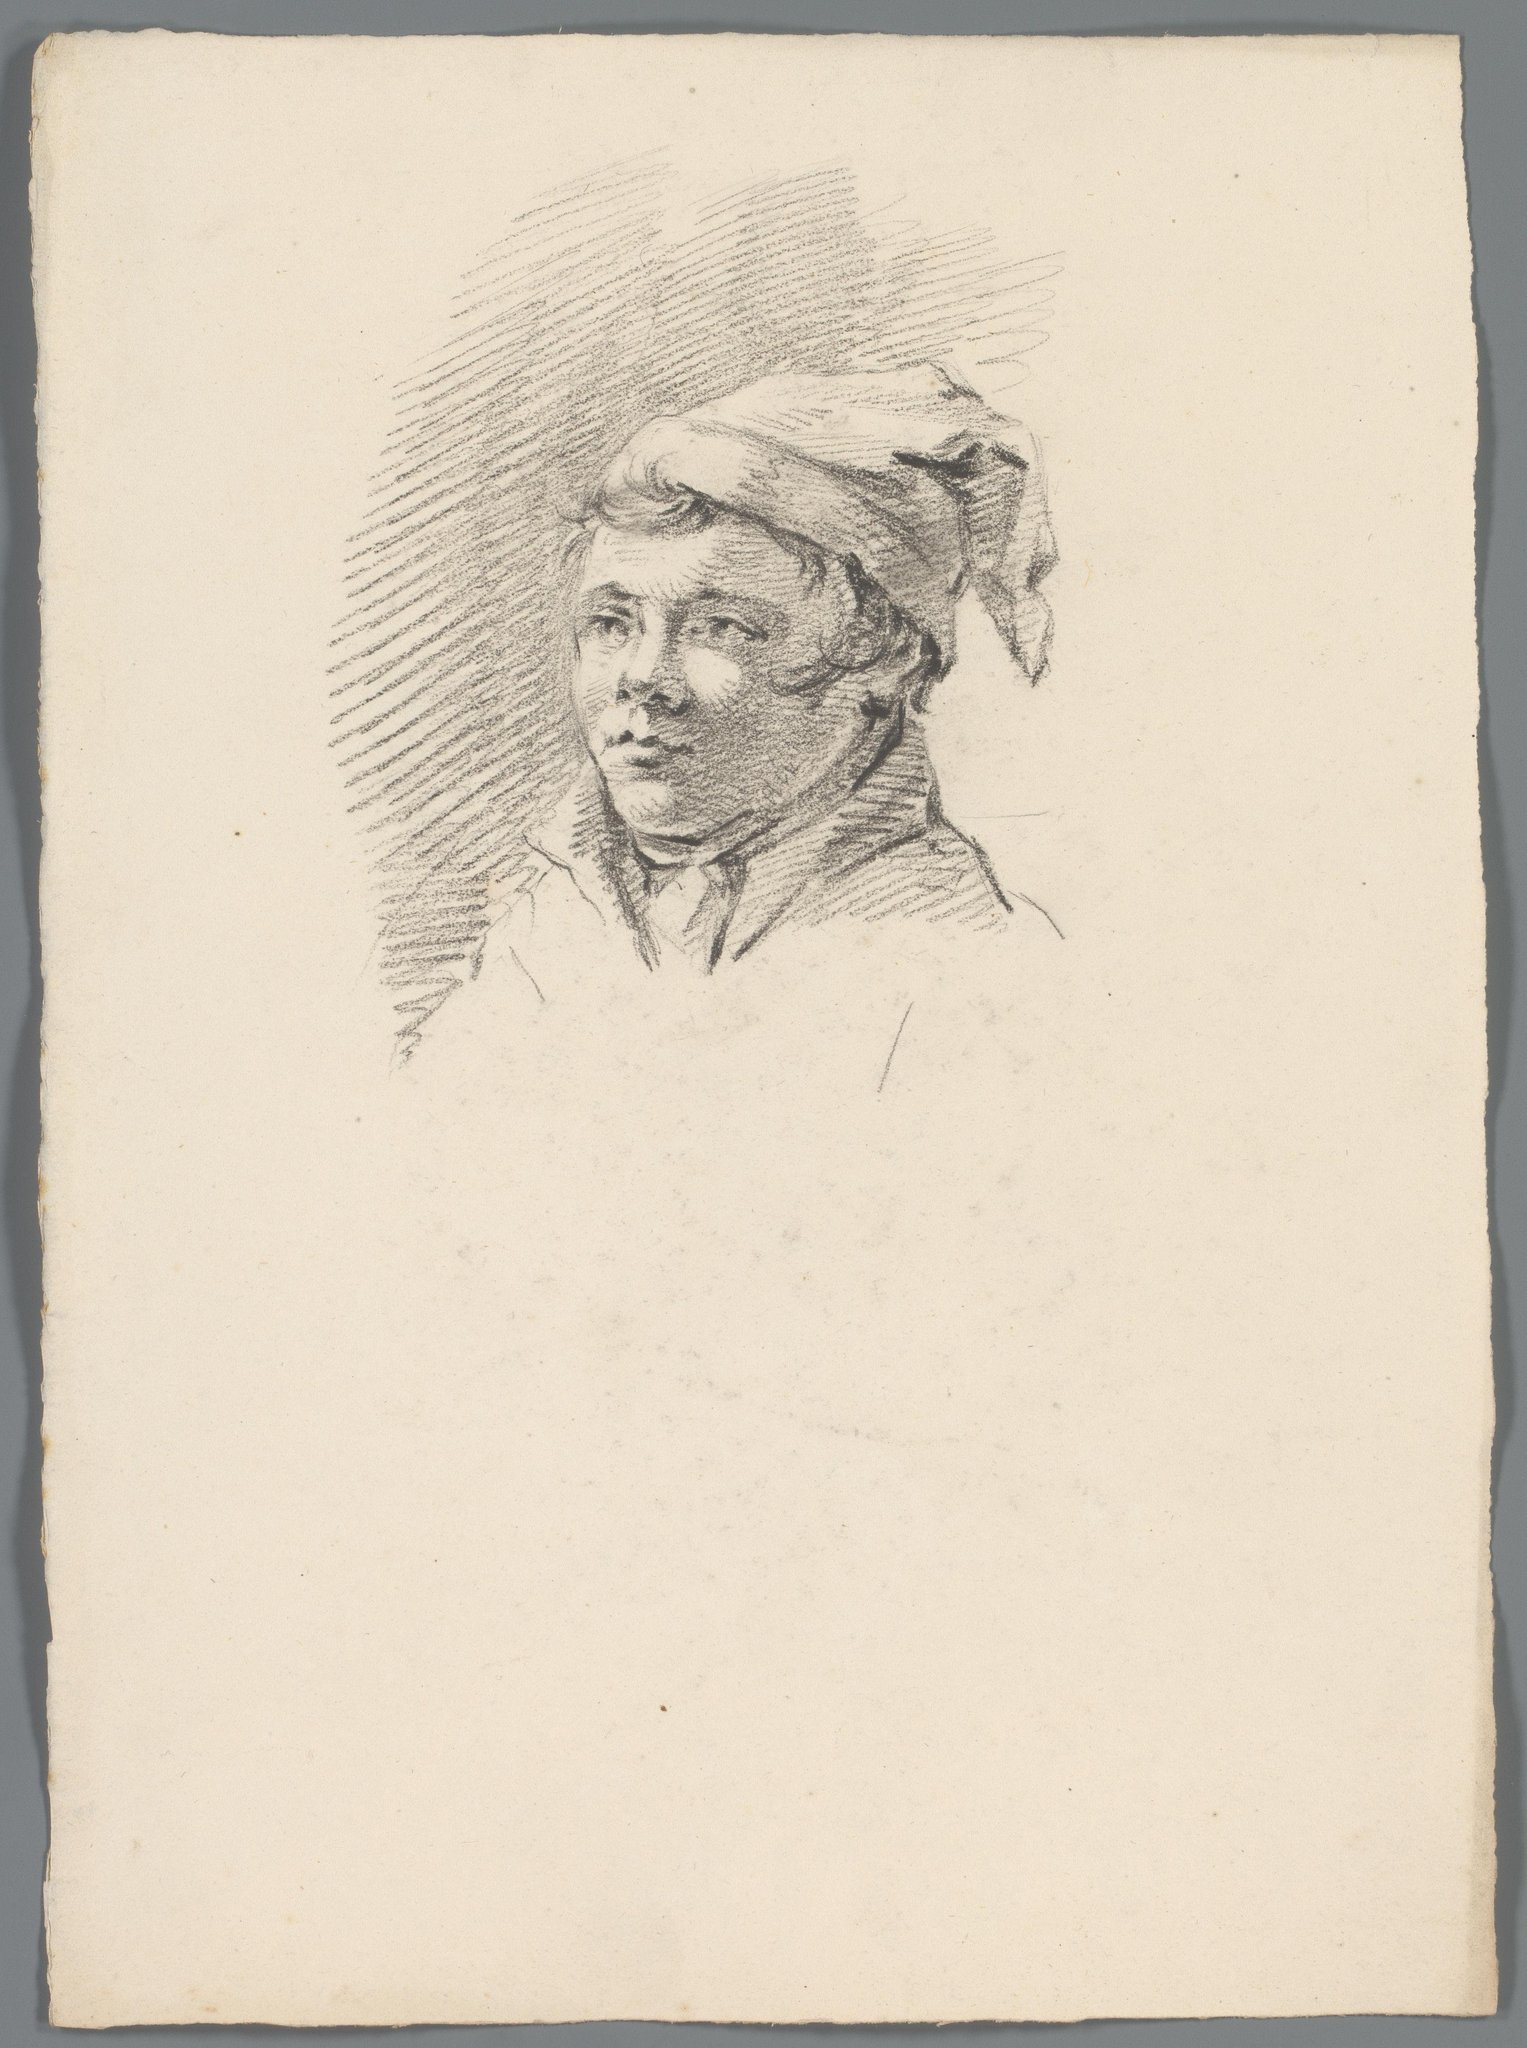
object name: drawing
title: Portret van een onbekende man of jongen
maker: Anonymous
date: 1820-1830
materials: chalk, paper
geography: the hague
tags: historical persons not known by name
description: Tekeningen waarschijnlijk ontstaan bij het Haagse kunstgenootschap ‘Tot Nut der Tekenkunst’, waar twee keer per week tekenavonden werden georganiseerd met geklede modellen.